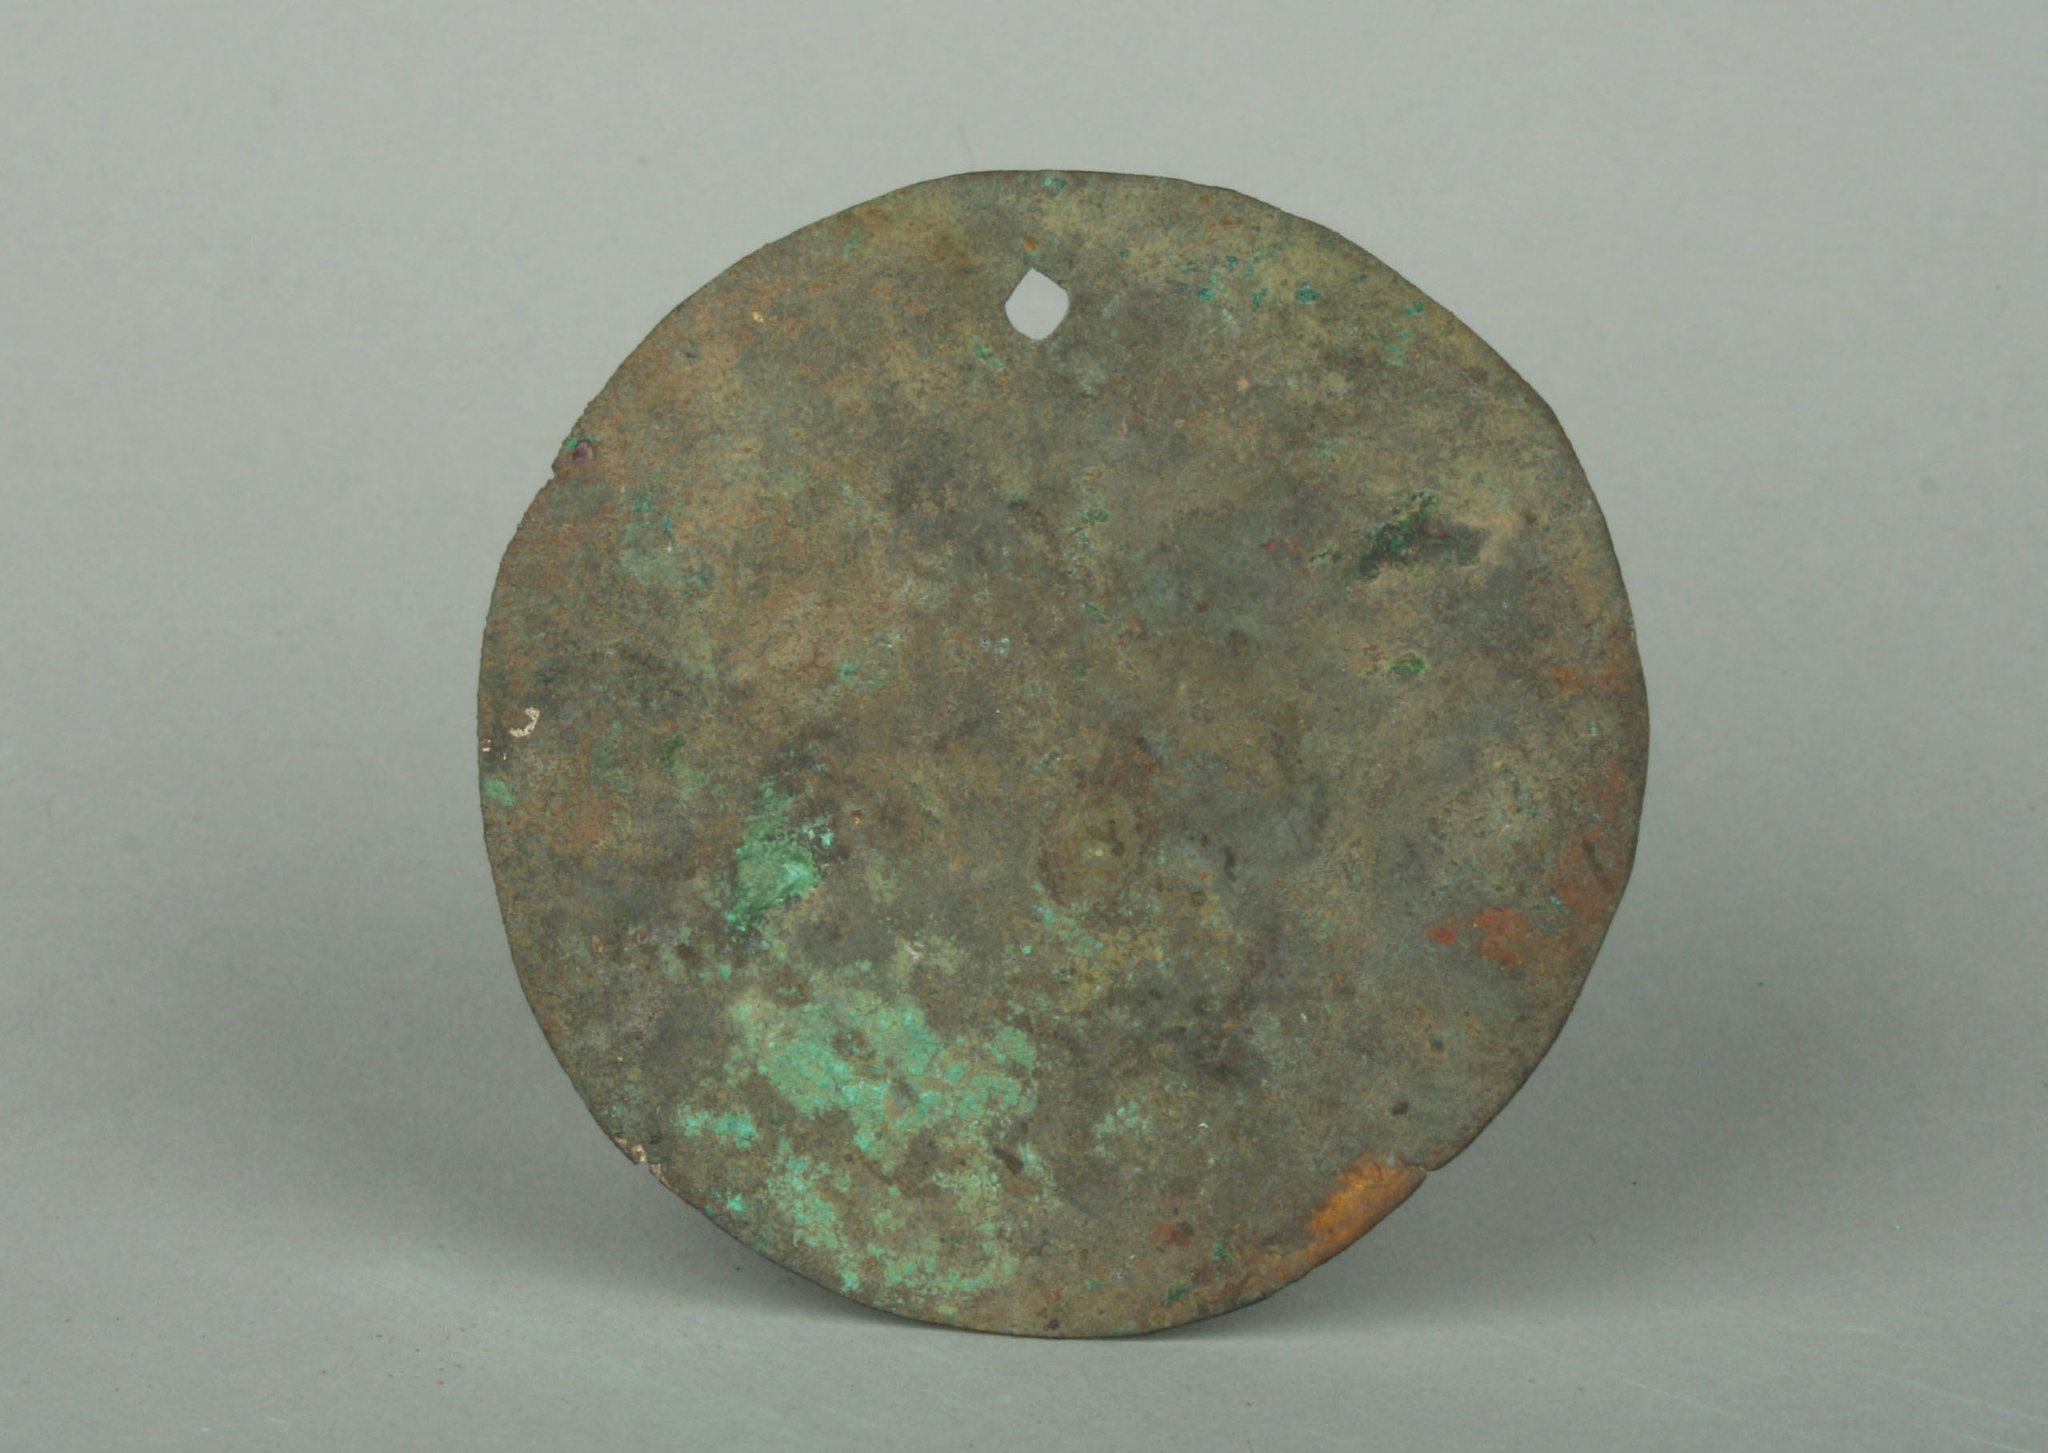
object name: plaque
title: Round Plaque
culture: vicús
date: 300 BCE-200 CE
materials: copper, gilt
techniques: hammering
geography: peru